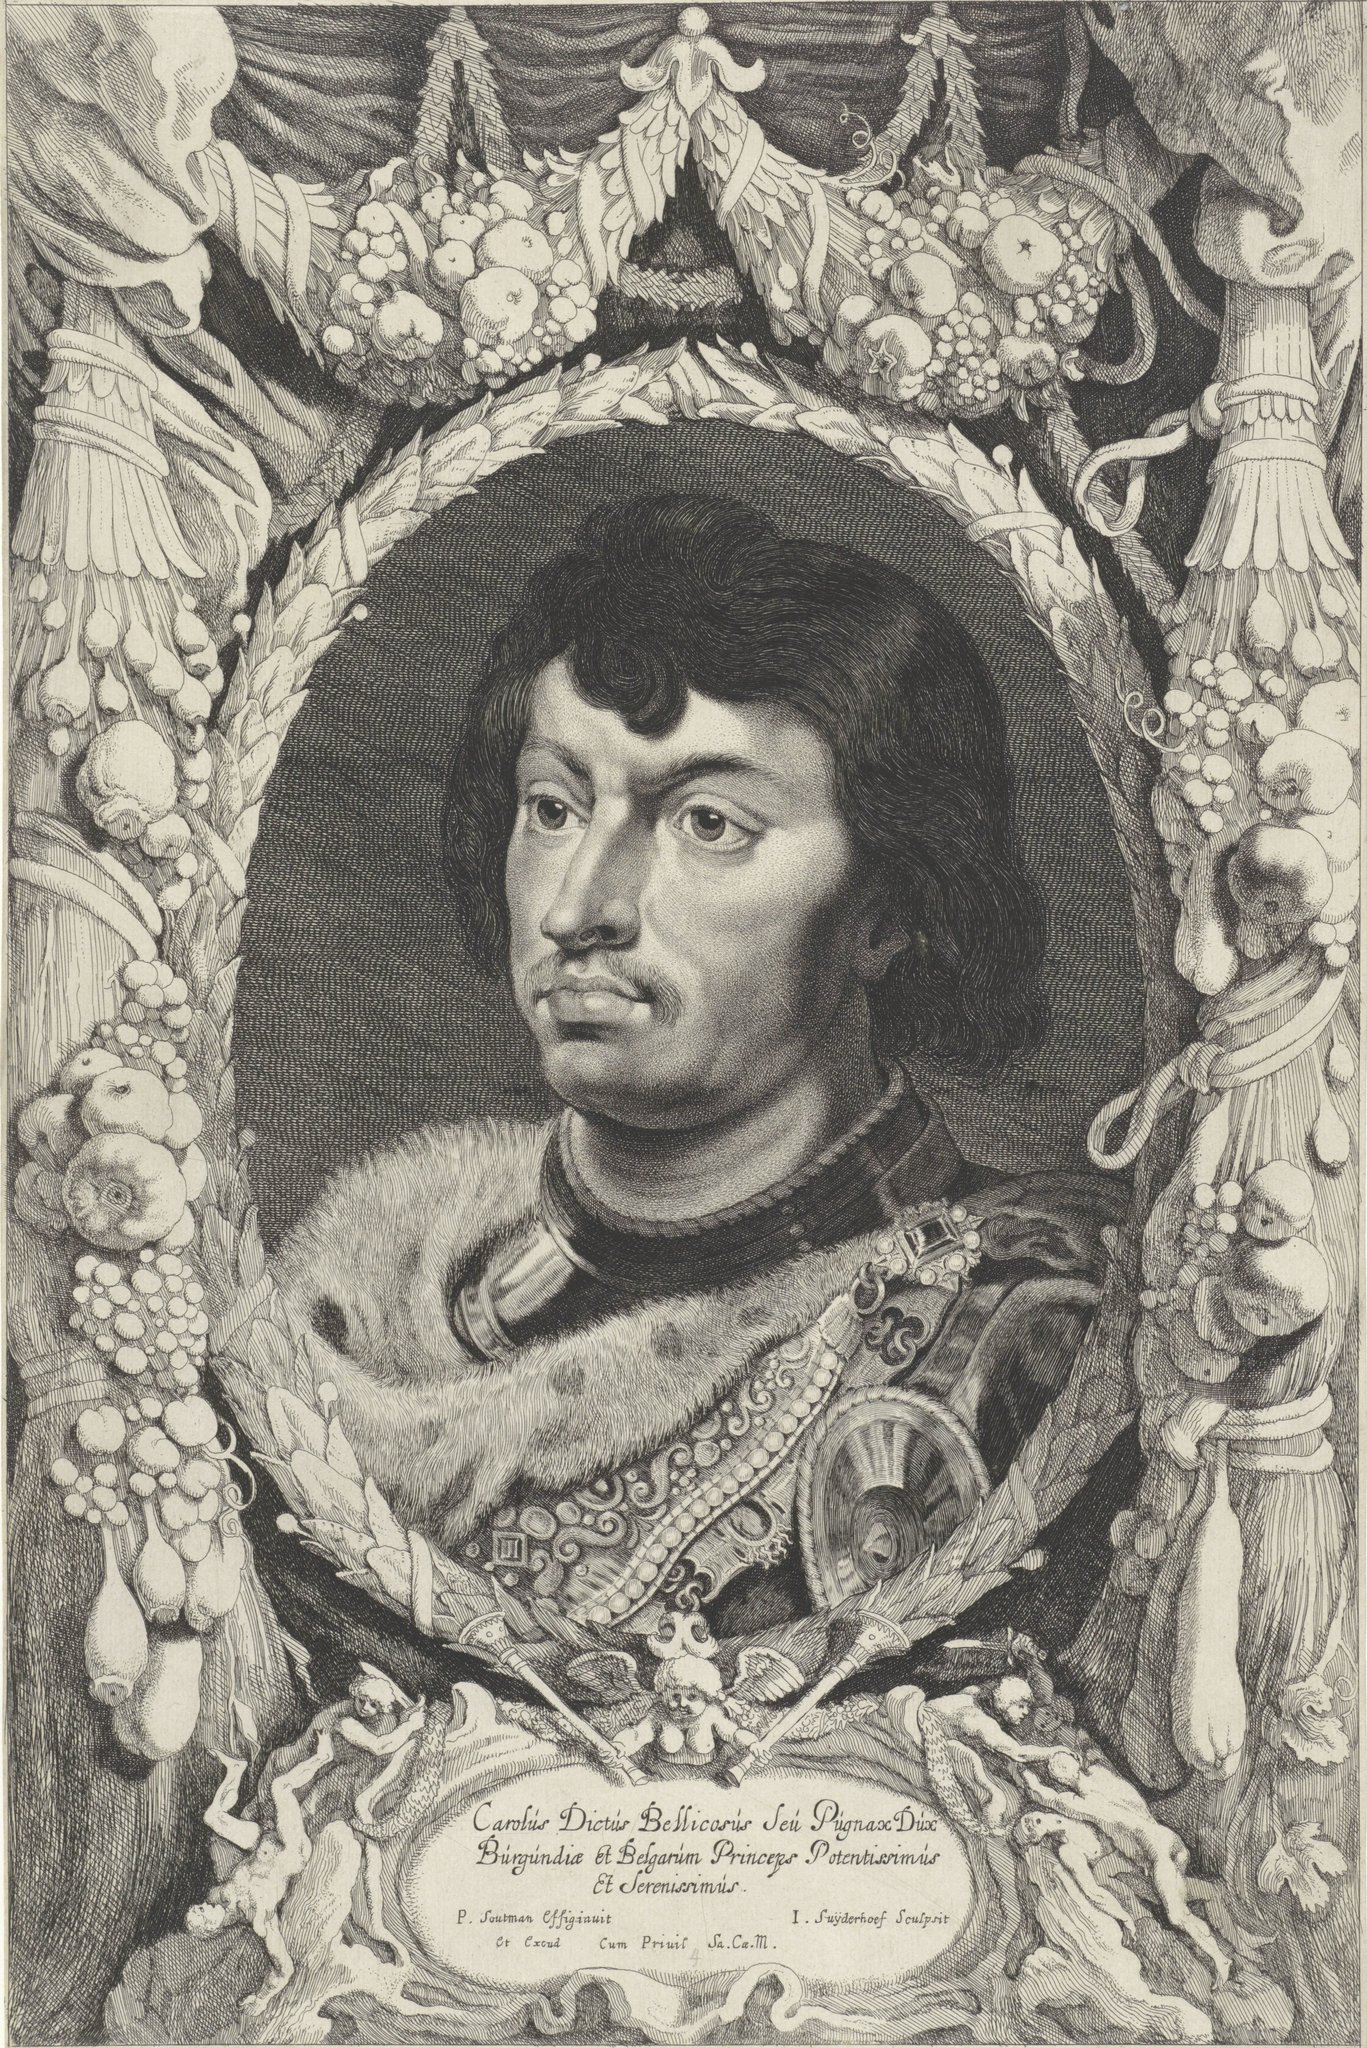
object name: print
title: Portret van Karel de Stoute, hertog van Bourgondië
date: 1644-1650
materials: paper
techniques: engraving, etching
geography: haarlem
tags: charles the bold (duke of burgundy), ornament ~ festoon, garland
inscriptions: collector's mark: Lugt 1425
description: Portret van Karel de Stoute, hertog van Bourgondië. Het portret is gevat in een ornamentele omlijsting van guirlandes met vruchten. Midden onder een cartouche met zijn naam en titel in het Latijn.